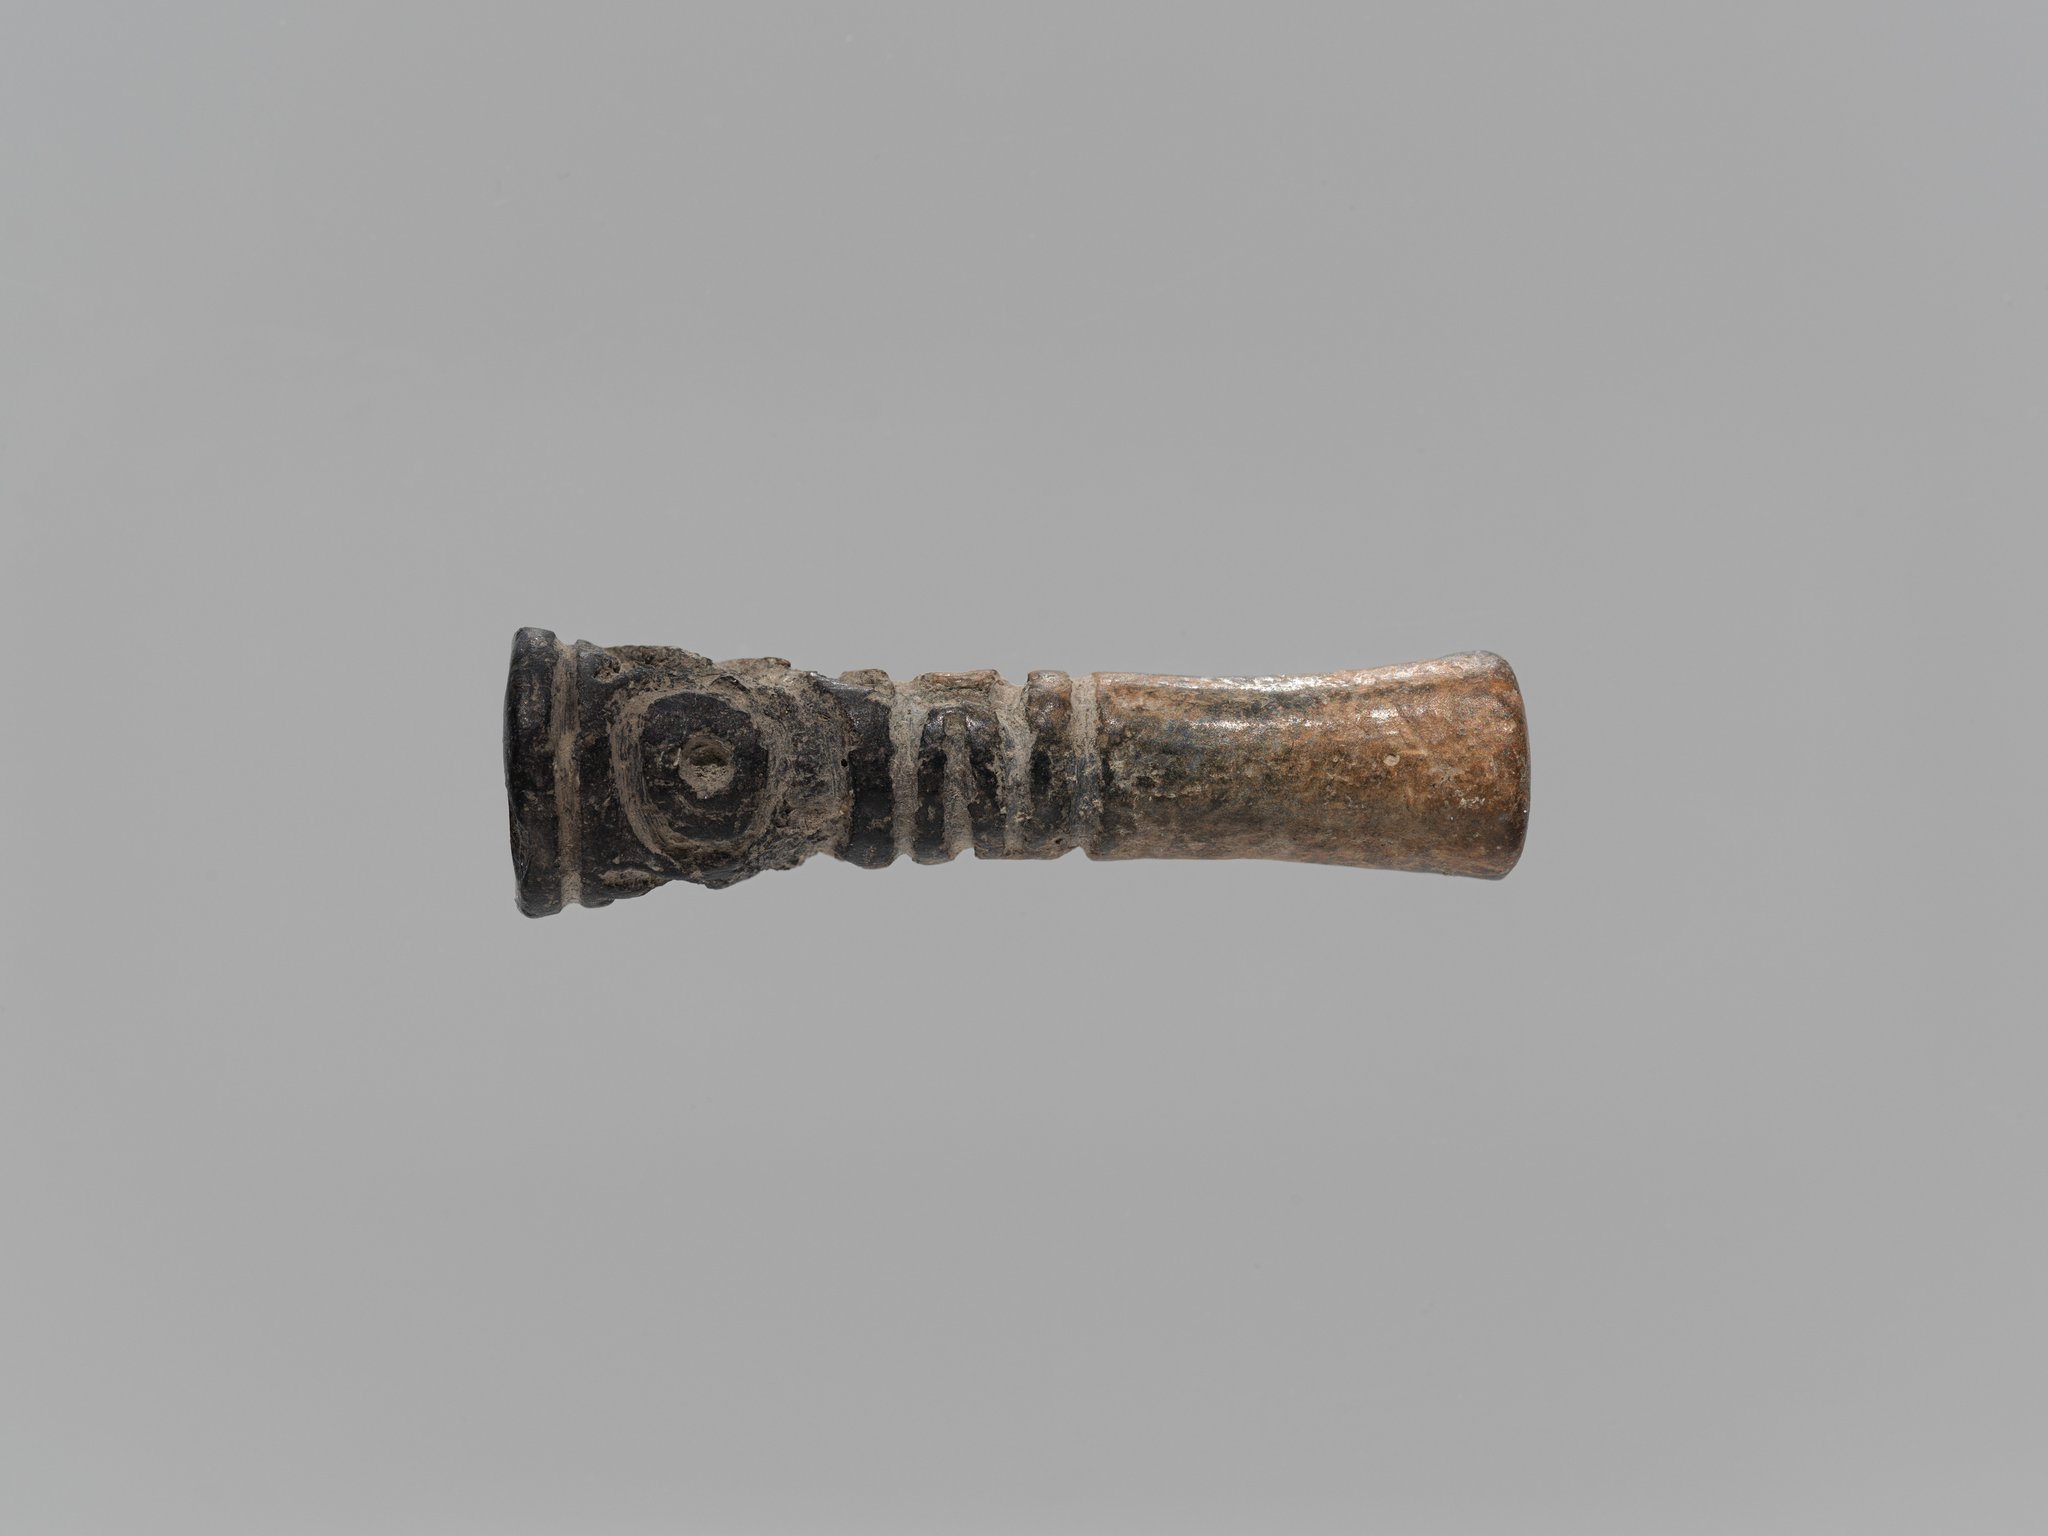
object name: ear ornament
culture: taíno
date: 901-1500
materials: ceramic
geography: dominican republic